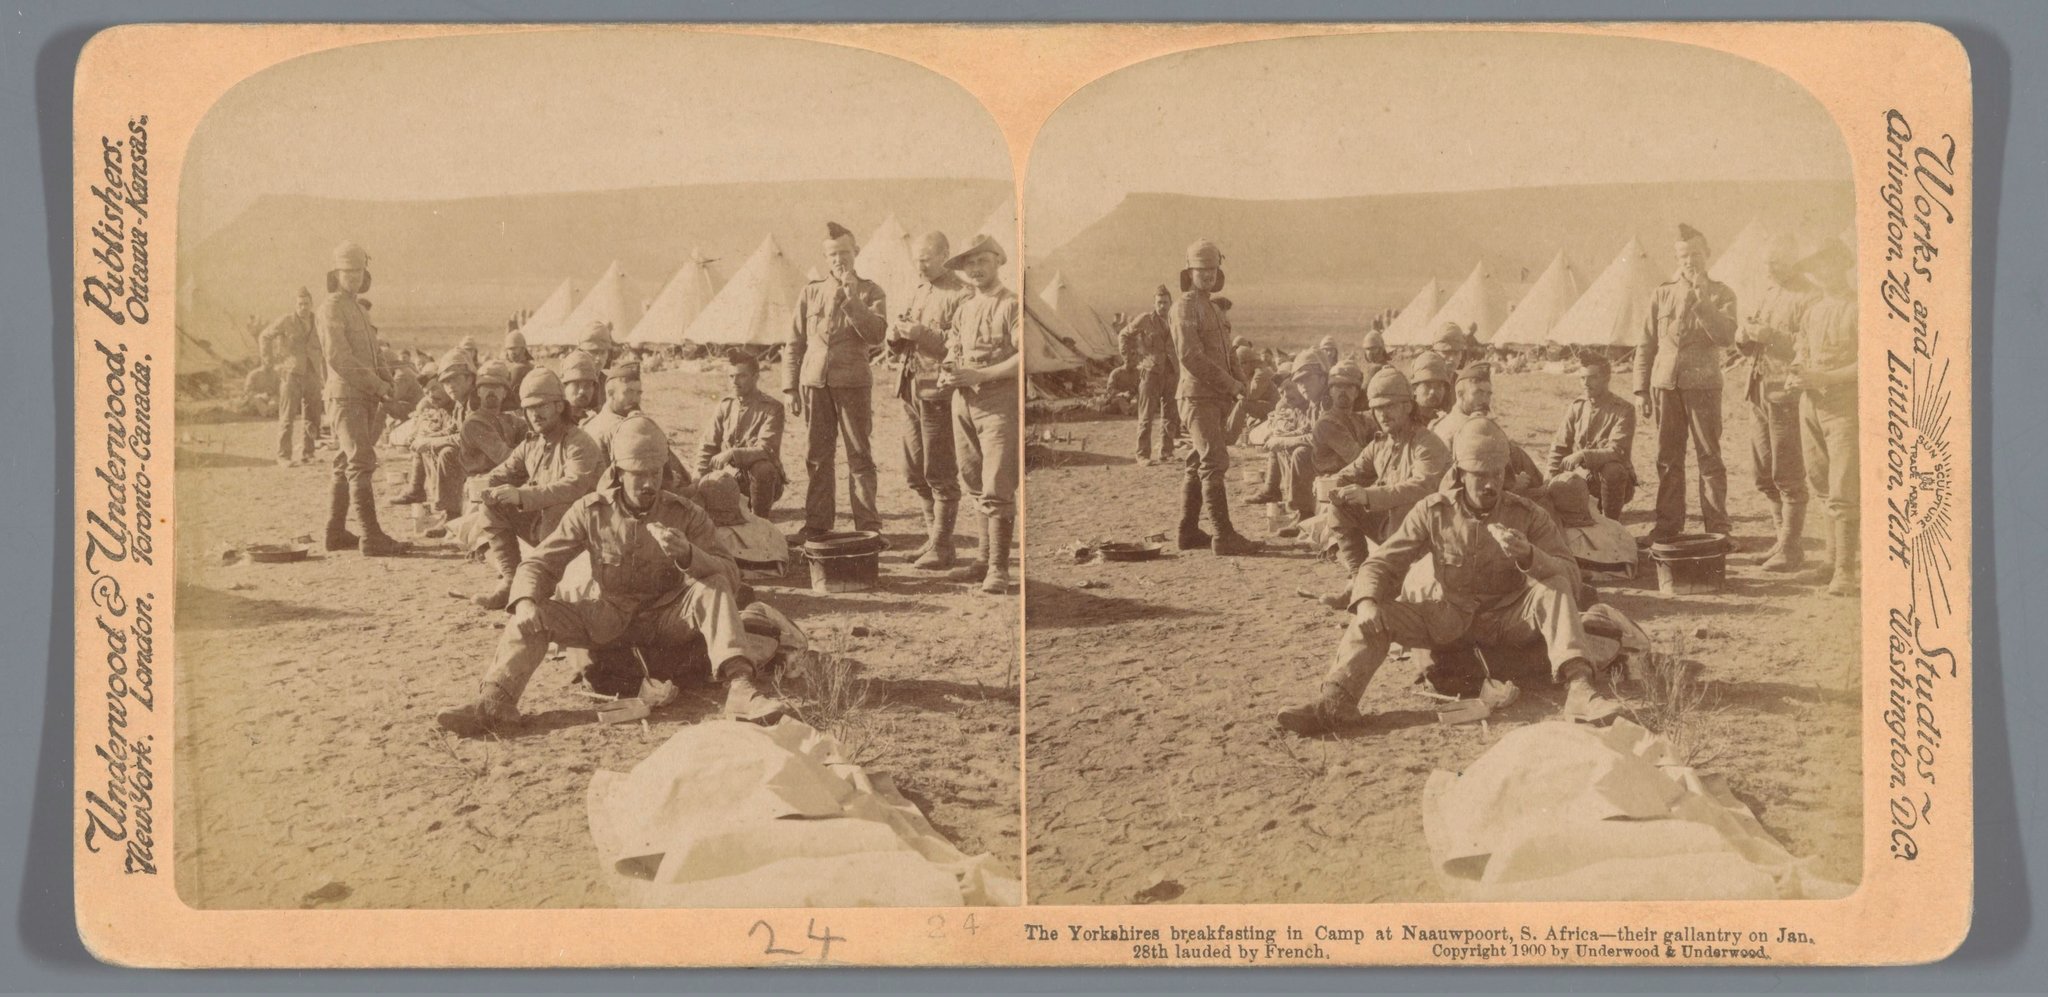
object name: stereograph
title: Britse soldaten ontbijten in hun kamp bij Noupoort in Zuid-Afrika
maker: Anonymous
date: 1900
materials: cardboard, paper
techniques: albumen print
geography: noupoort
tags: (military) camp with tents, breakfast - cc - out of doors, the soldier; the soldier's life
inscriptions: number: ‘24’, inscription, inscription: ‘Works and Studios ~/ Arlington, N.J. Littleton, N.H. Washington, D.C.’, number: ‘24’, copyright notice: ‘Copyright 1900 by Underwood & Underwood.’